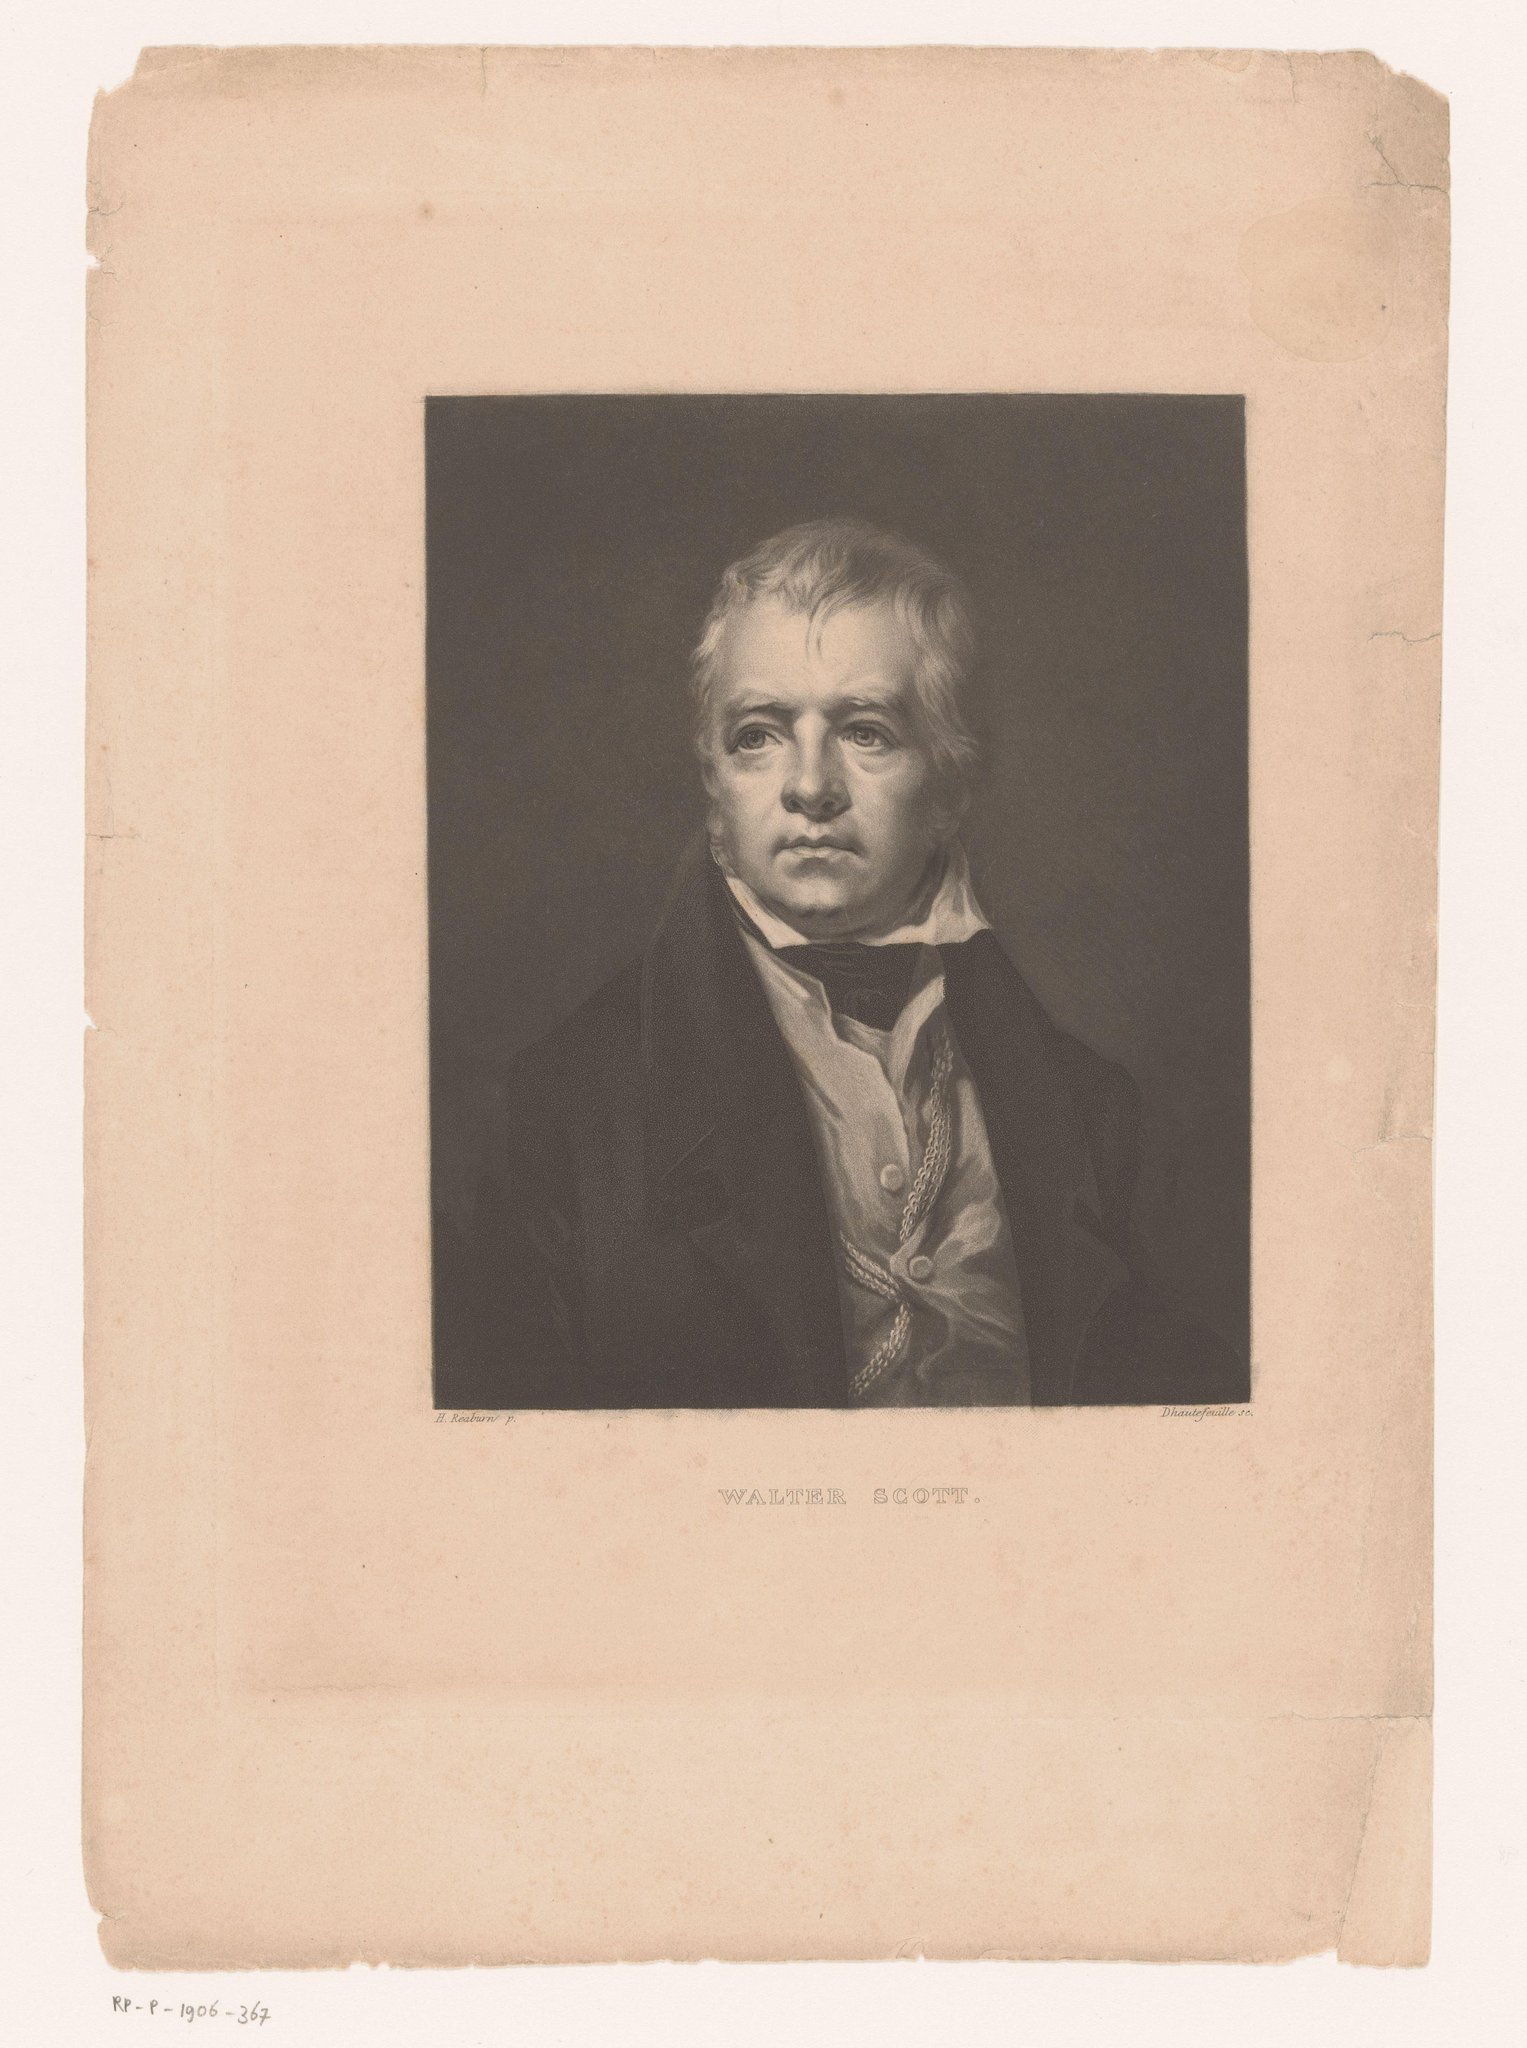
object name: print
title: Portret van Sir Walter Scott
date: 1869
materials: paper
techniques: aquatint, engraving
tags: walter scott, historical persons, portrait of a writer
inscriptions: collector's mark: Lugt 2228